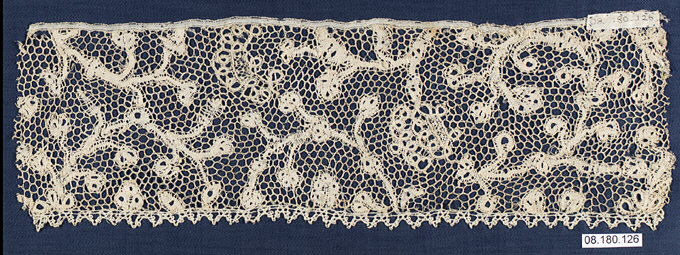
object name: fragment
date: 1601-1700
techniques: lace